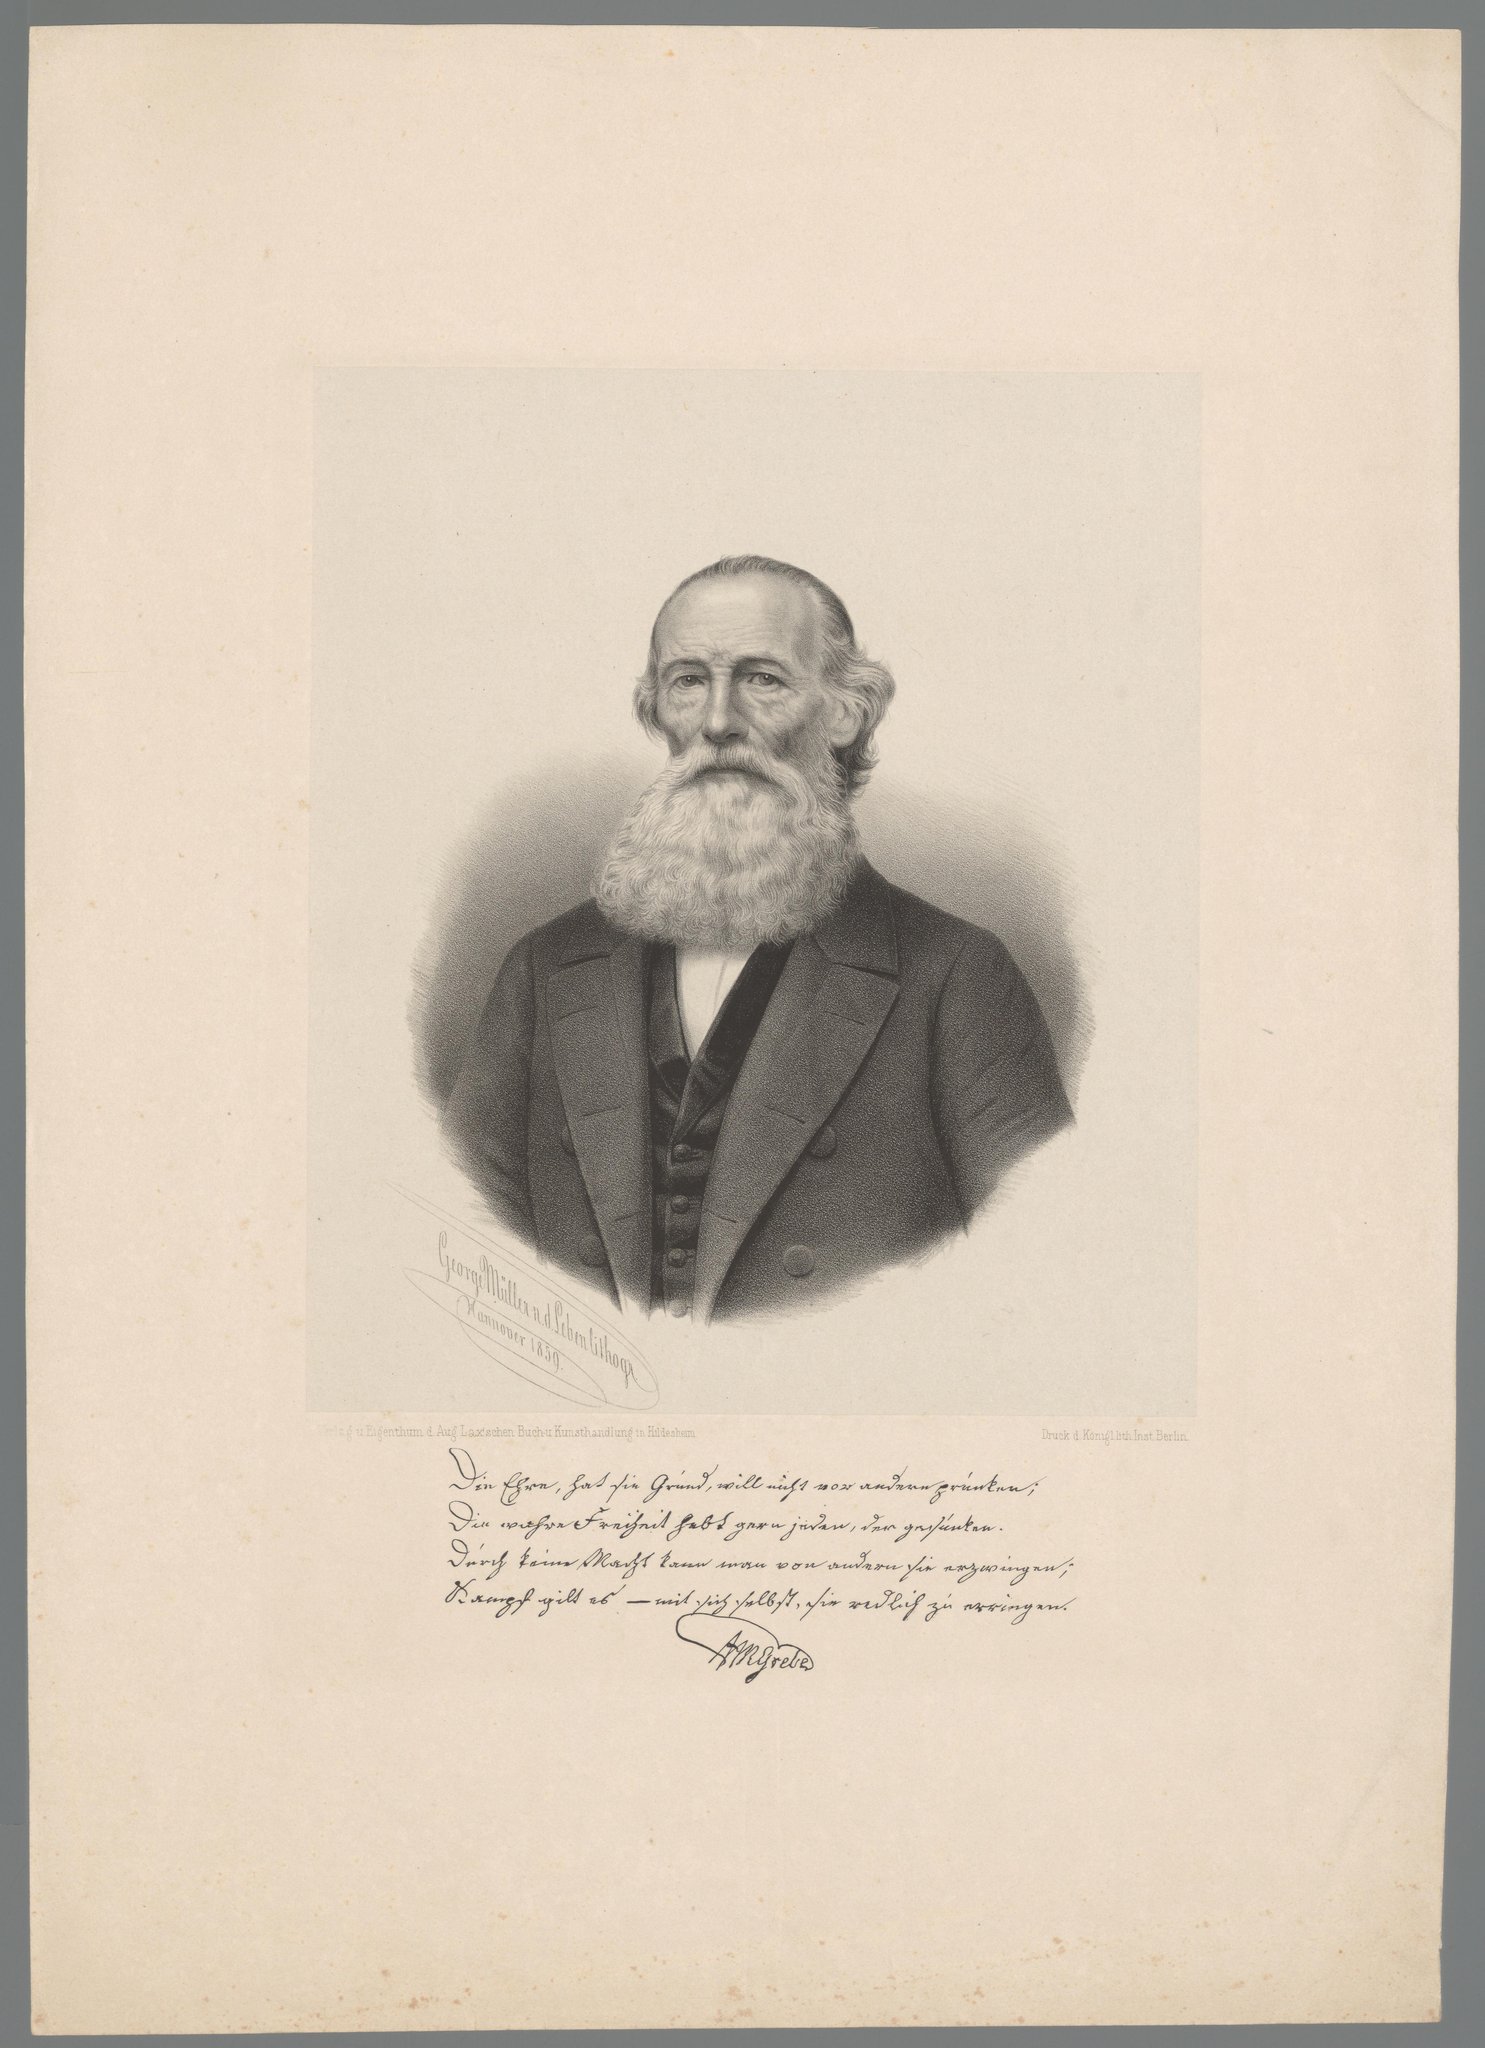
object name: print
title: Portret van een onbekende man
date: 1859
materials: paper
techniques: lithograph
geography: berlin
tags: adult man, historical persons, beard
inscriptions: collector's mark: Lugt 2228